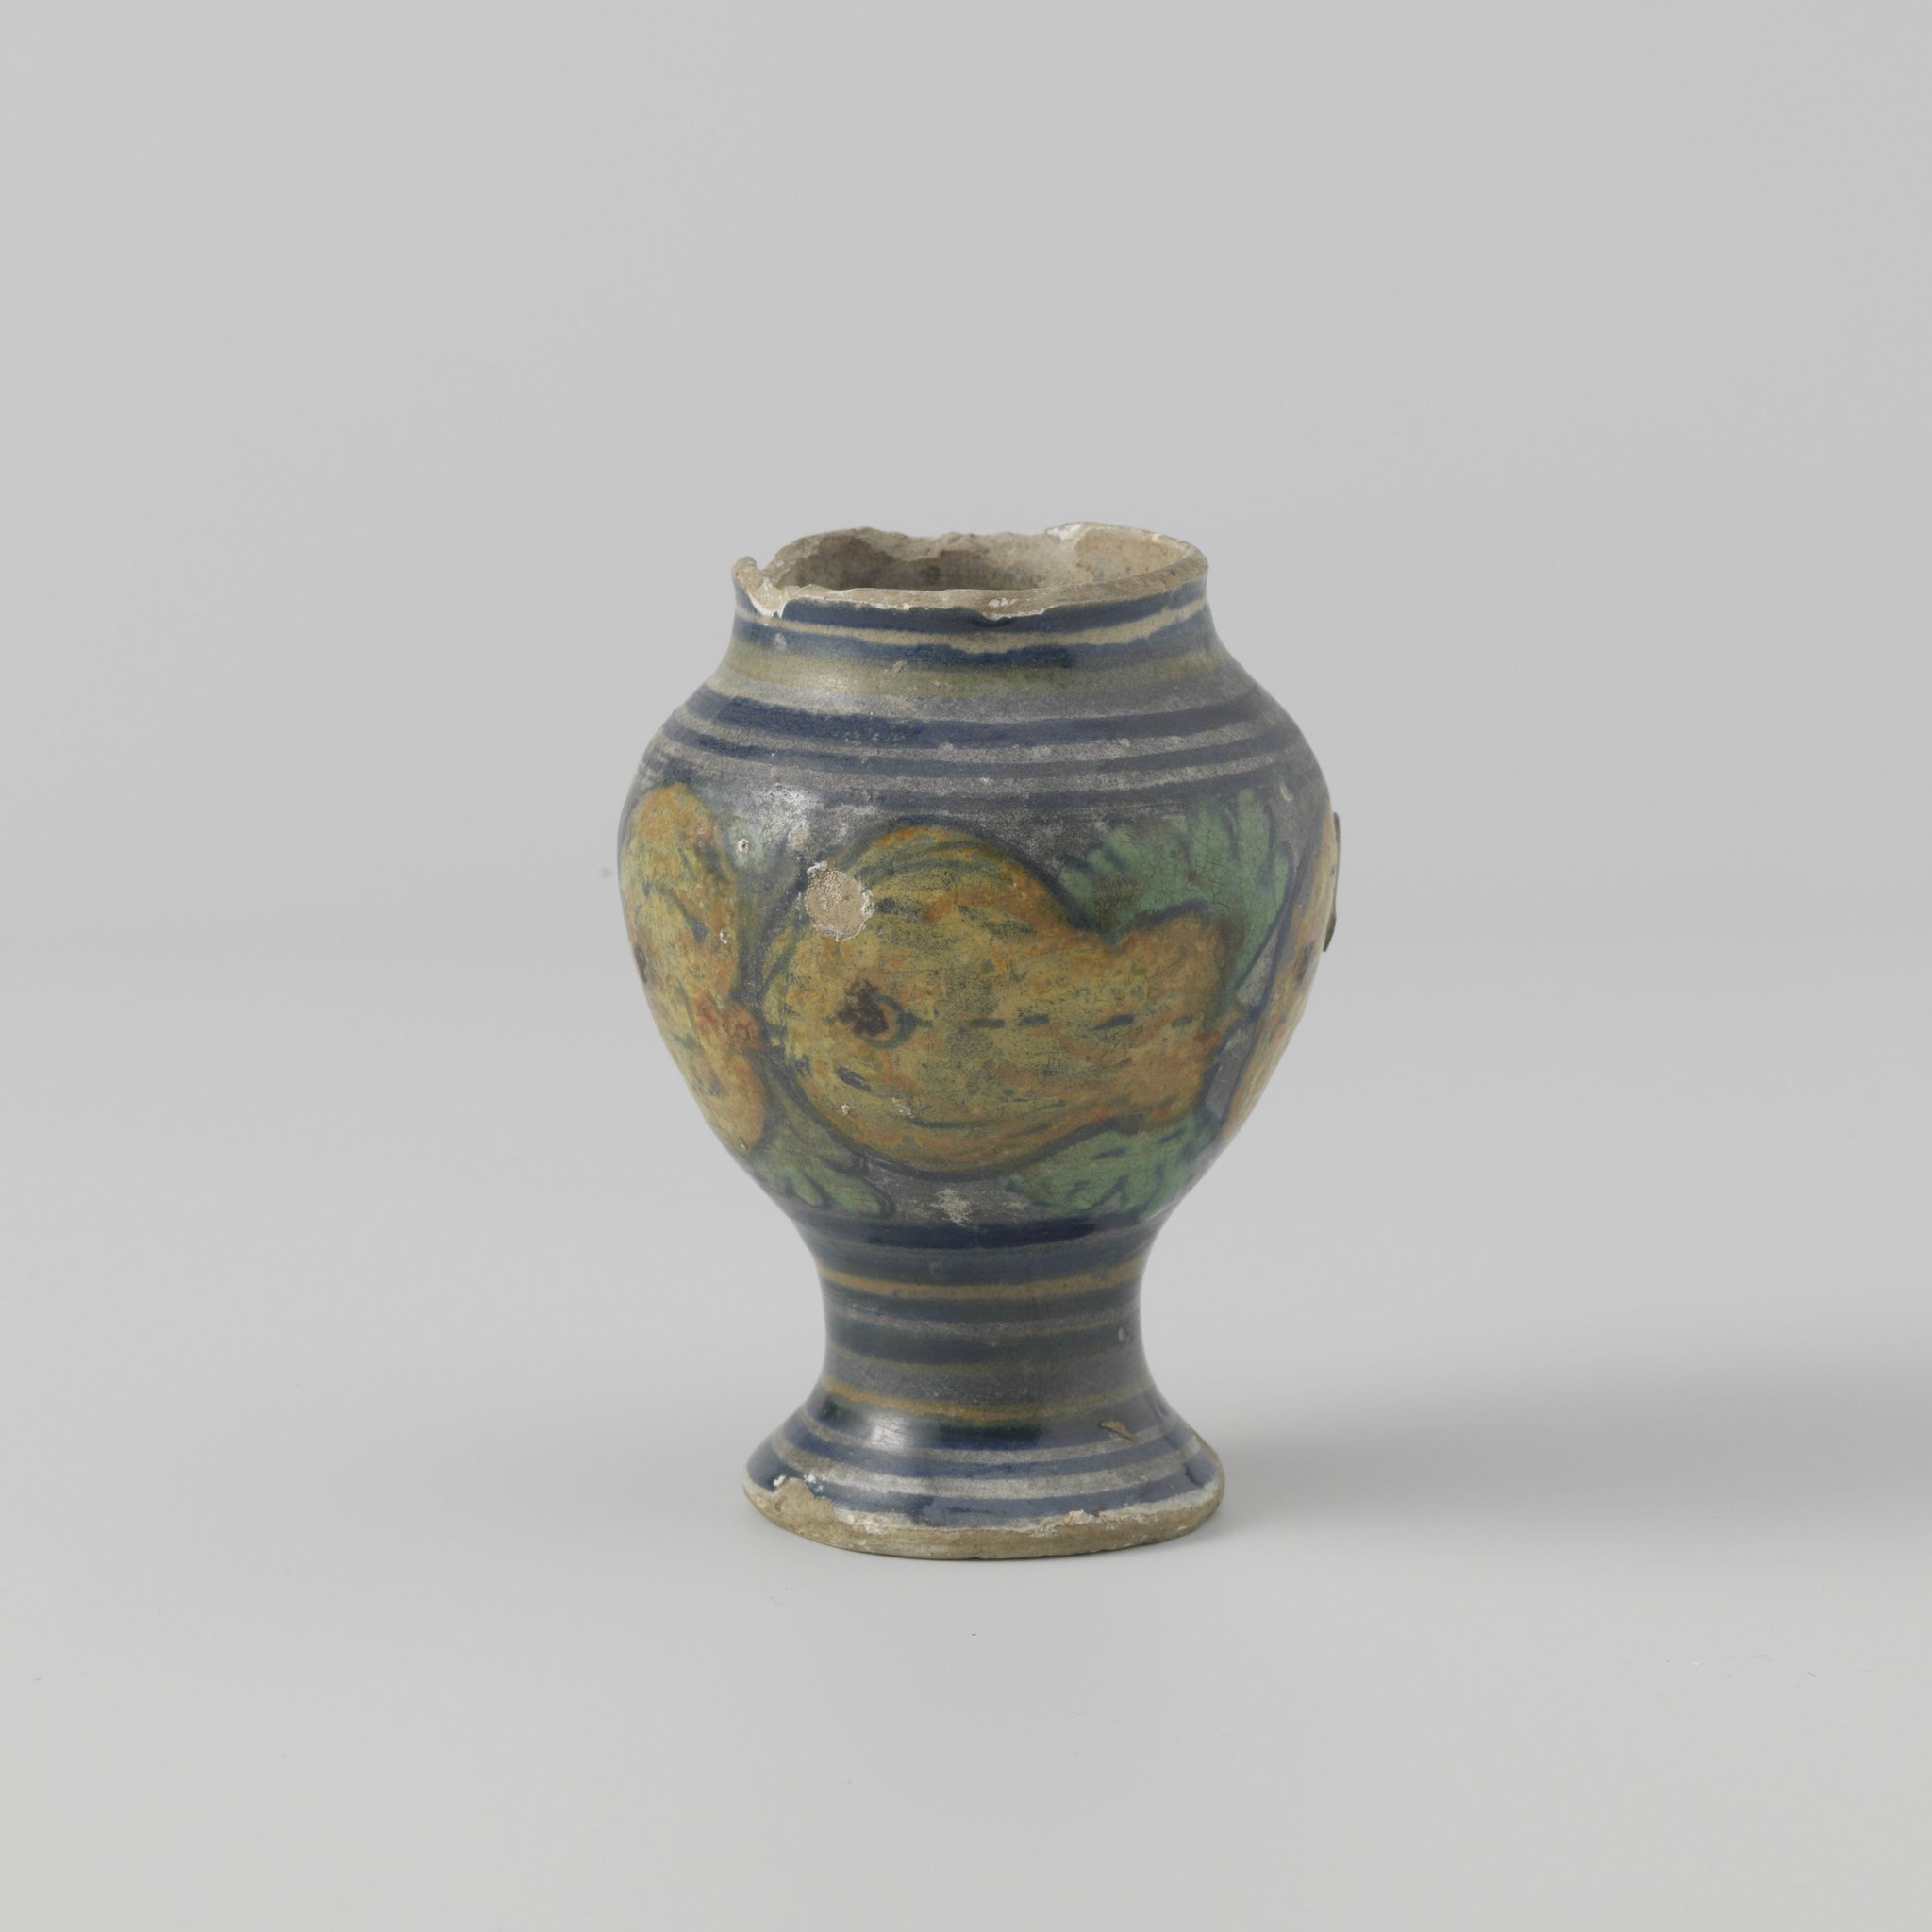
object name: vase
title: Vaas of pot, balustervormig en veelkleurig beschilderd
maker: Anonymous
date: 1575-1600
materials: earthenware, glaze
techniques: maiolica, painted, polychromy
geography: netherlands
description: Balustervormige vaas van veelkleurig beschilderde majolica. Op de voet en langs de bovenrand zijn horizontale lijnen geschilderd en op de buik vruchten en bladen. De gebruikte kleuren zijn groen, geel en blauw.